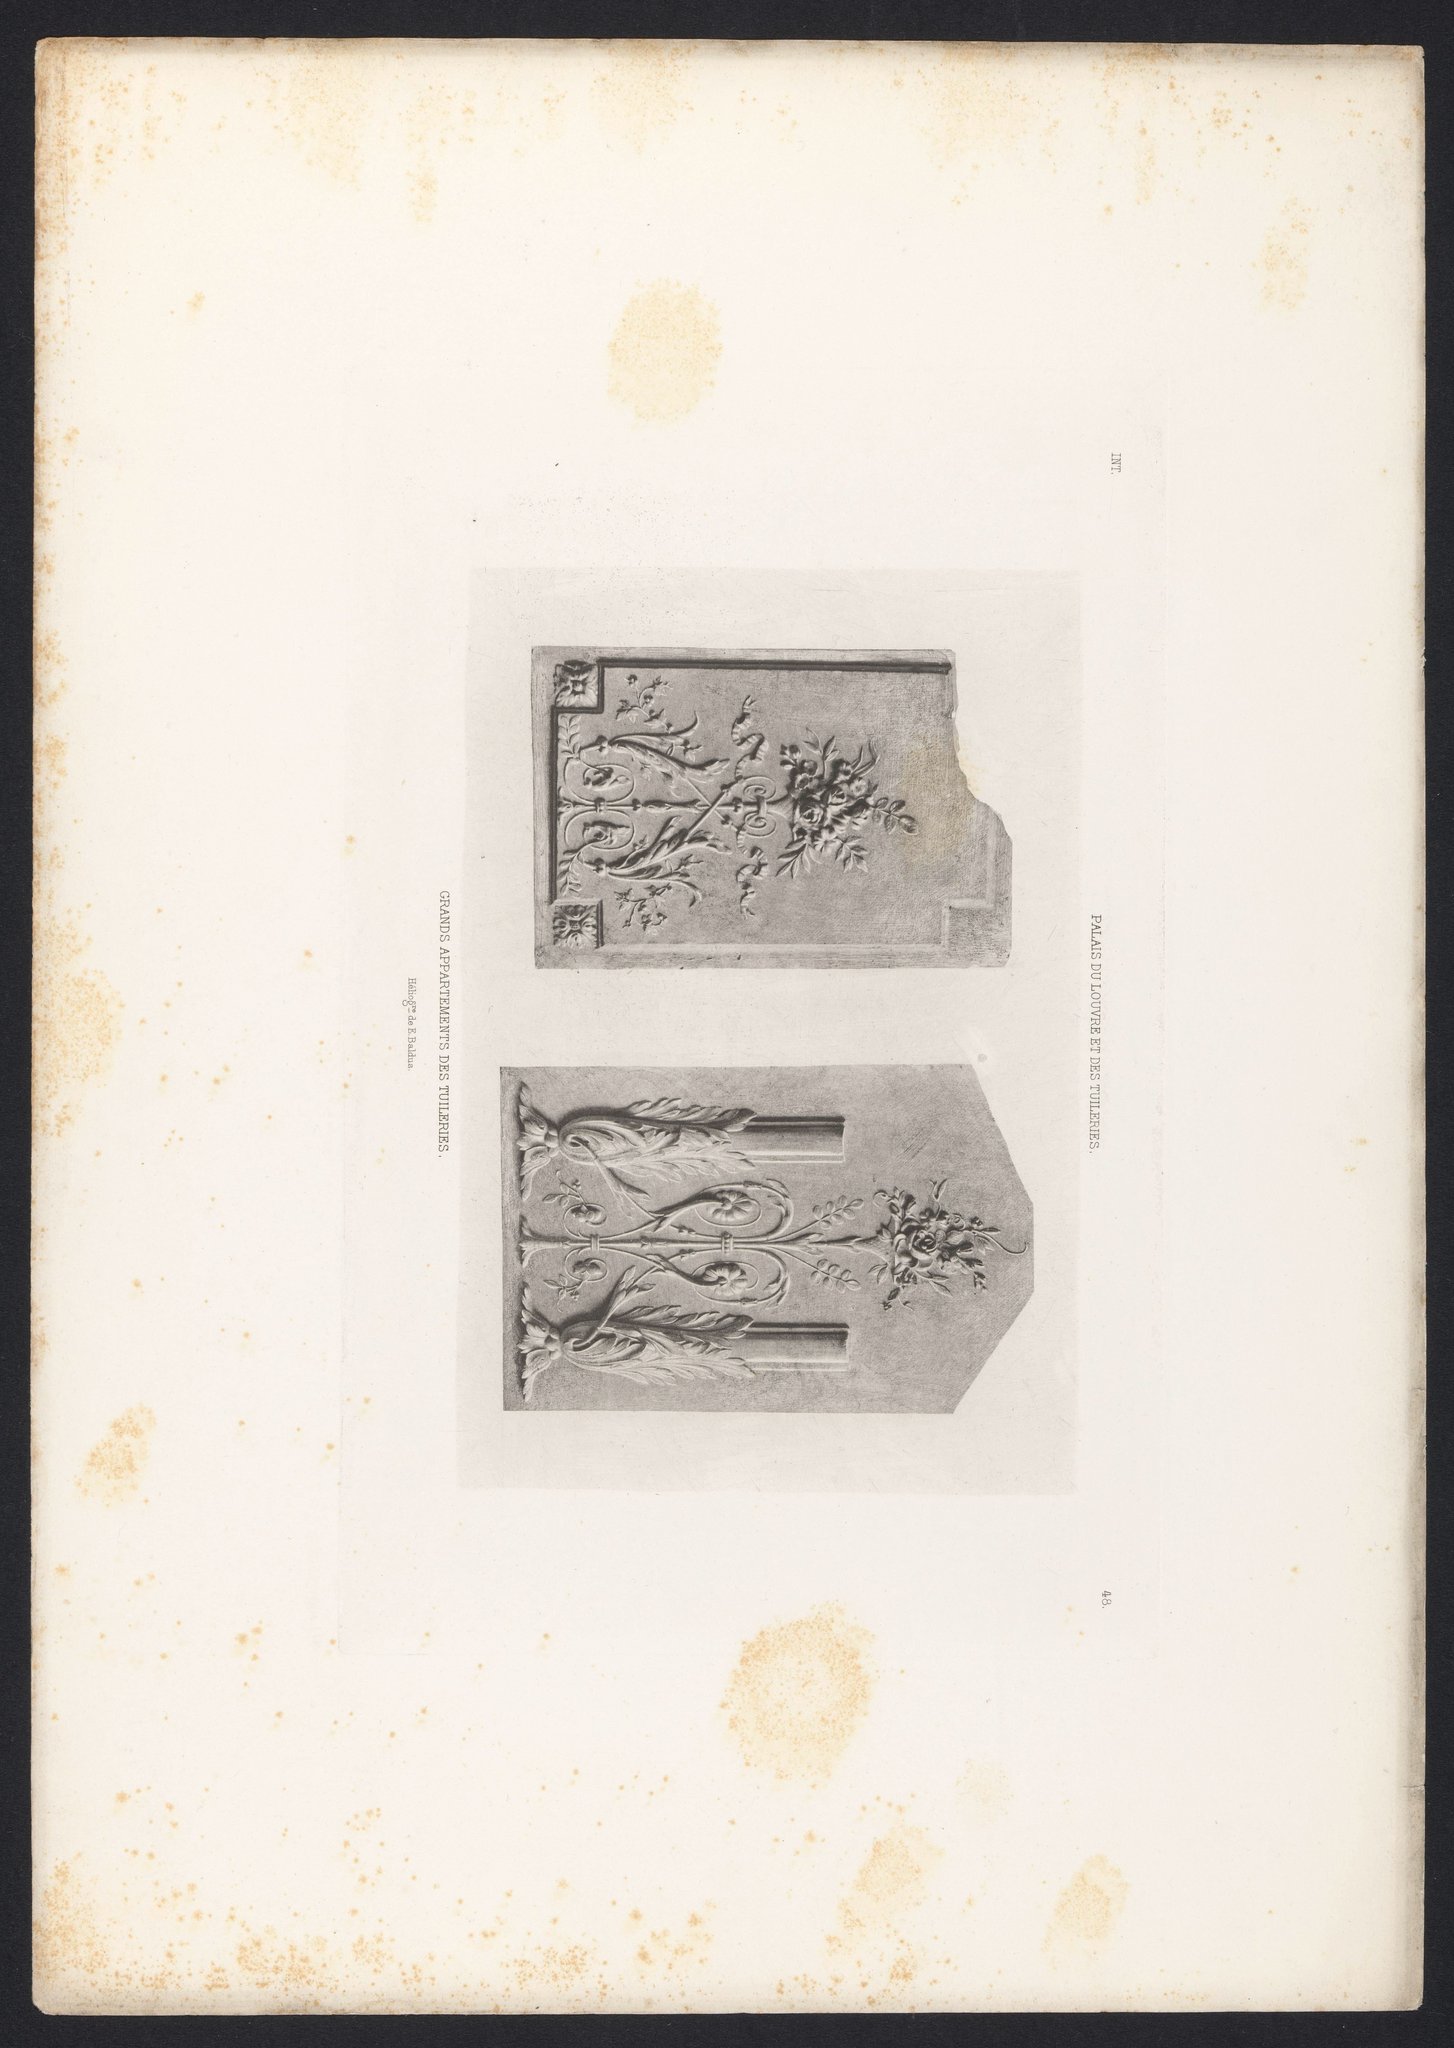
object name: page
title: Twee reliëfs uit het Palais des Tuileries te Parijs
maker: édouard denis baldus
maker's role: fotograaf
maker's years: 1813-1889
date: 1865-1870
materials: paper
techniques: photoaquatint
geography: france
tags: ornaments ~ art, sculpture (+ relief ~ sculpture)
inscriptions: number: ‘Int. 48.’